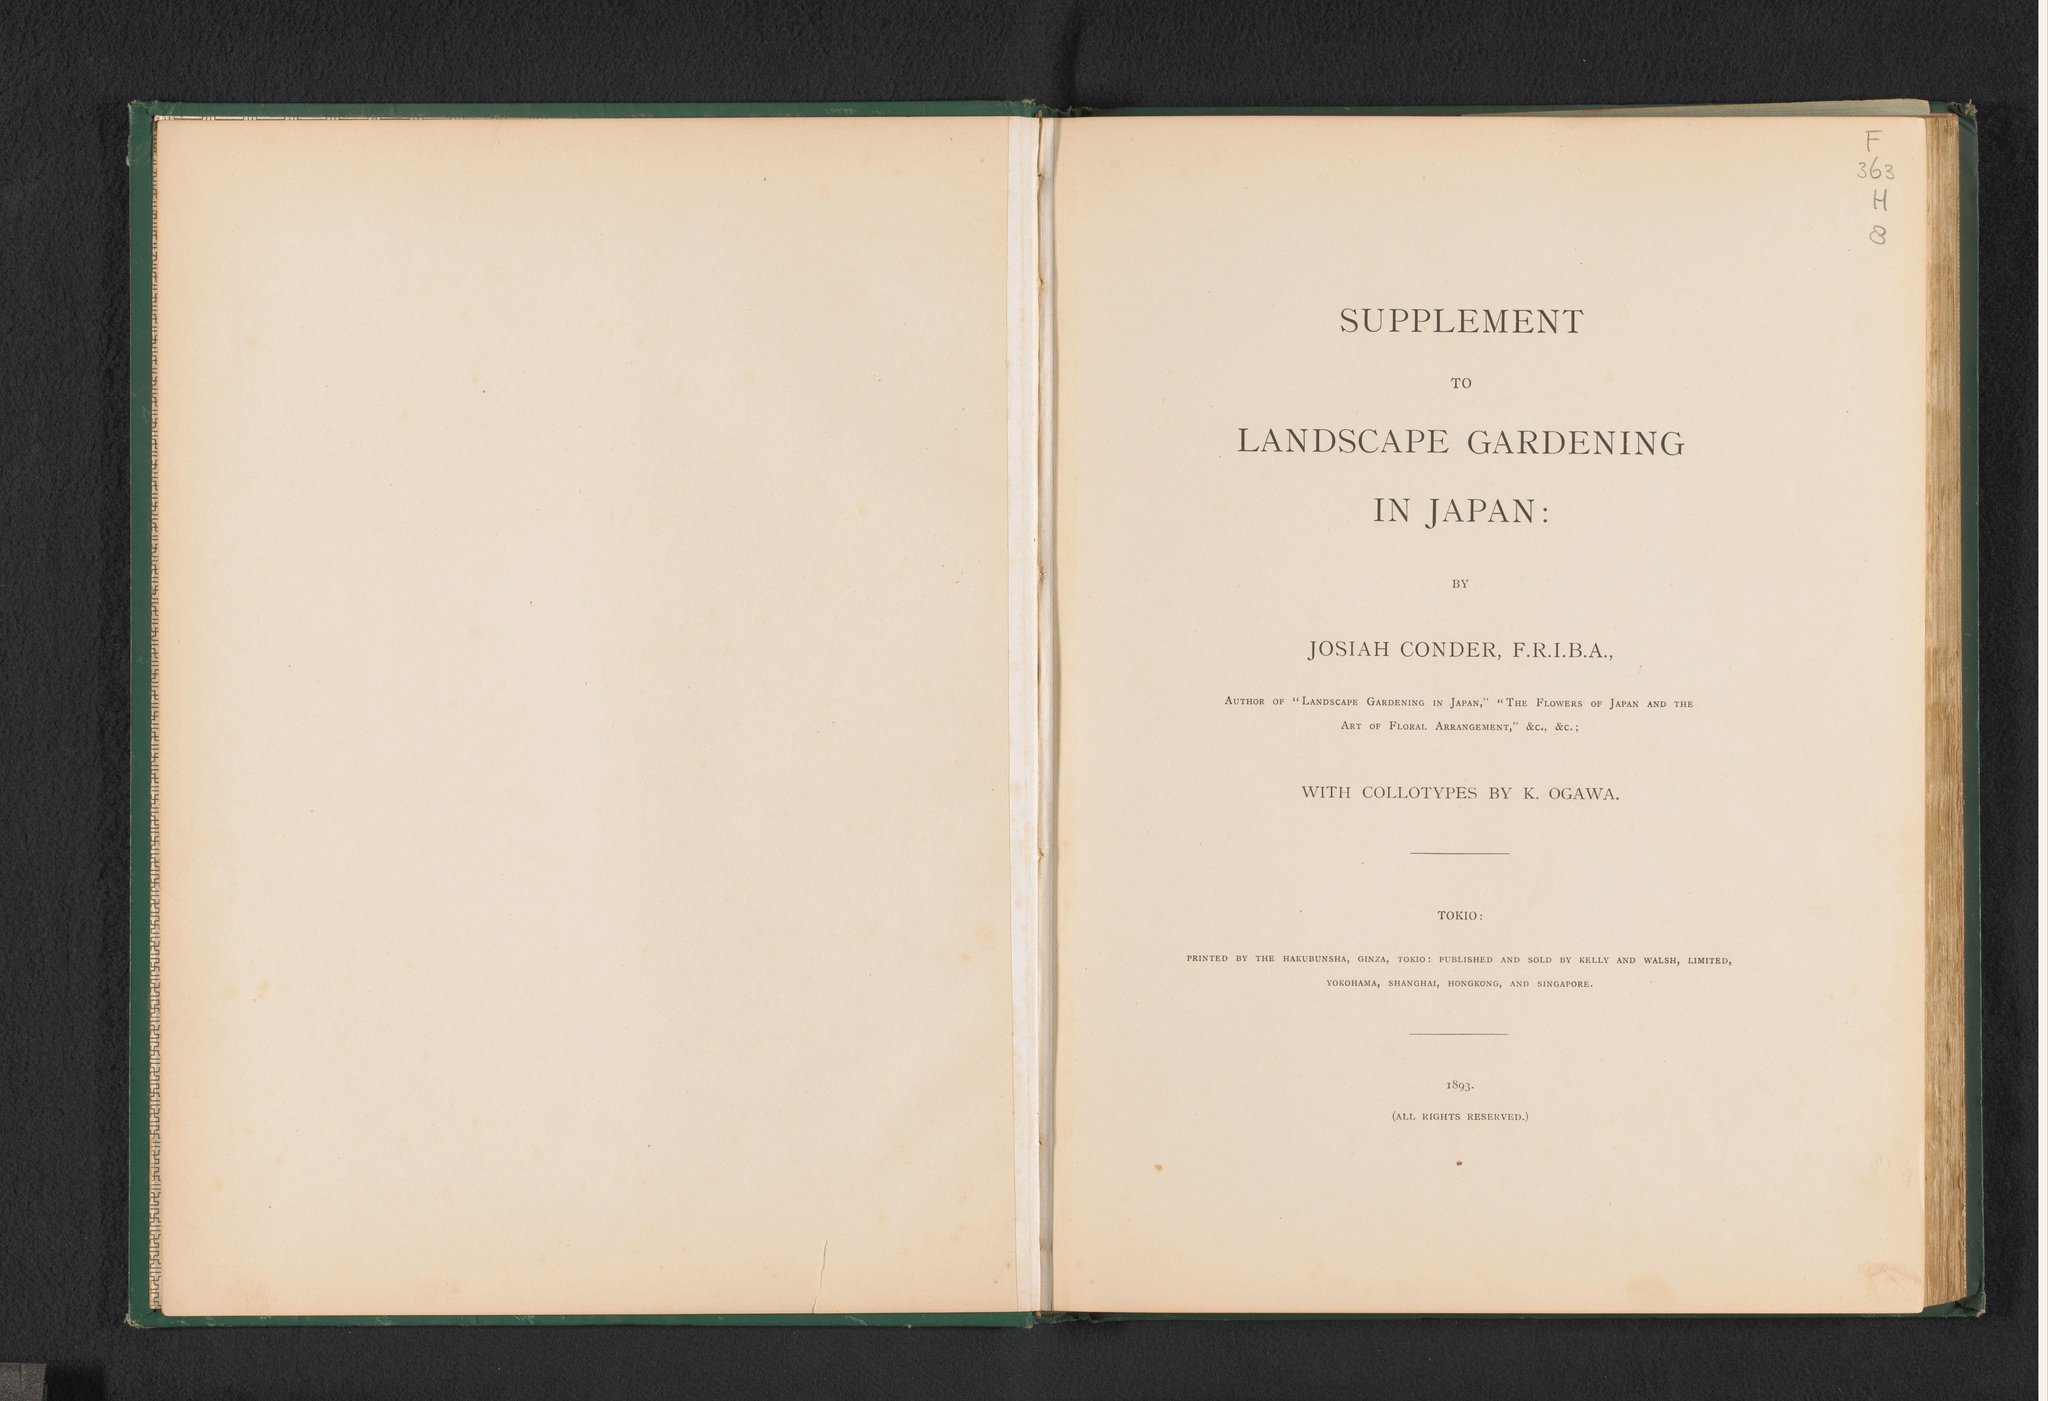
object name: book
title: Supplement to Landscape gardening in Japan / by Josiah Conder; with collotypes by K. Ogawa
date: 1893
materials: cardboard, linen, paper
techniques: photograph, decorated paper, printing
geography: yokohama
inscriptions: date: ‘NOV/ 1994’